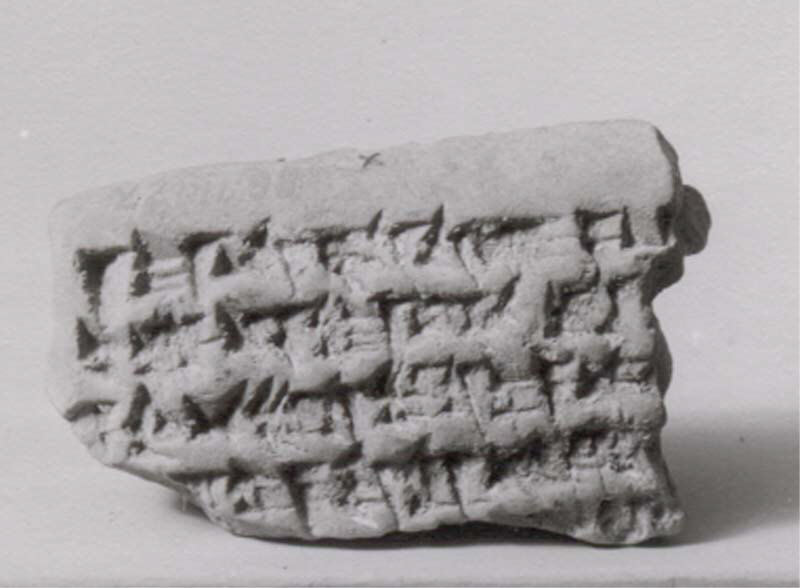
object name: cuneiform tablet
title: Cuneiform tablet: promissory note for silver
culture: achaemenid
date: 500 BCE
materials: clay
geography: mesopotamia